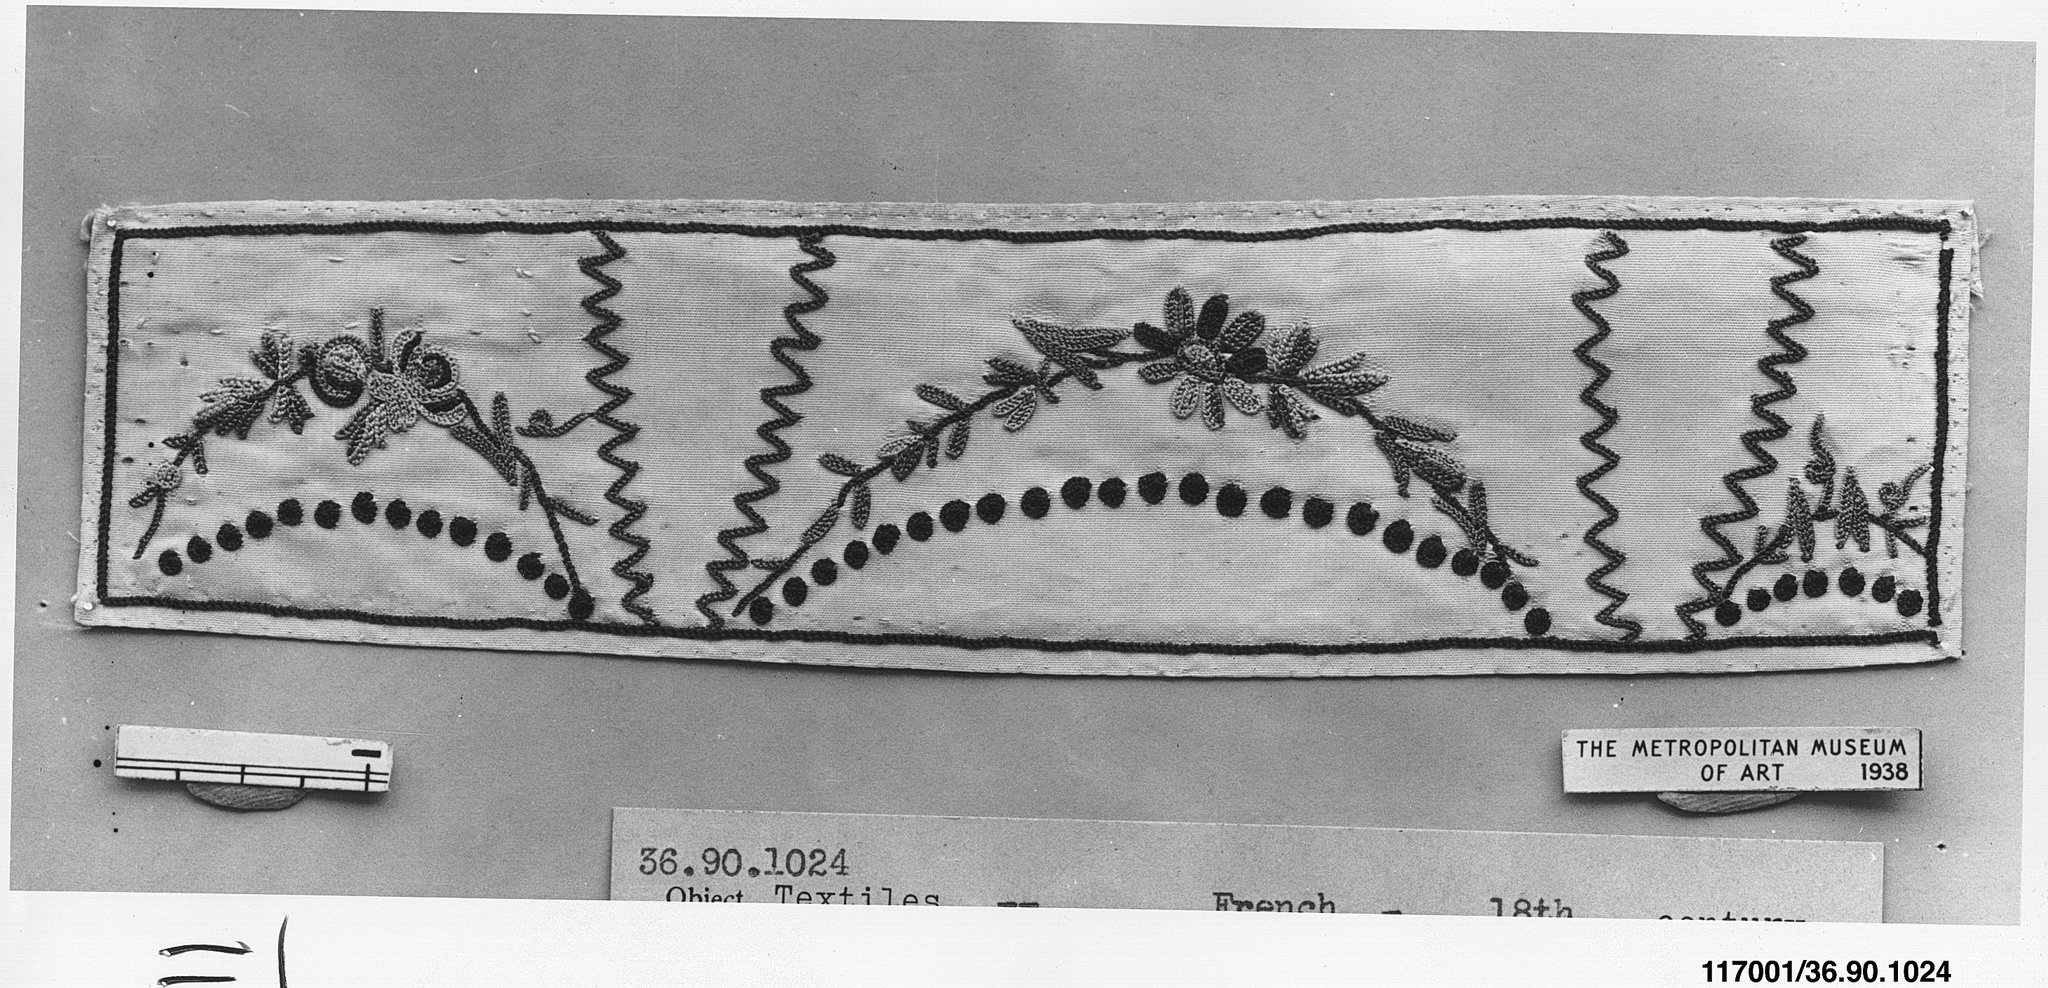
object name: pocket welt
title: Pocket welt from a waistcoat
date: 1701-1800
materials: silk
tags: flowers